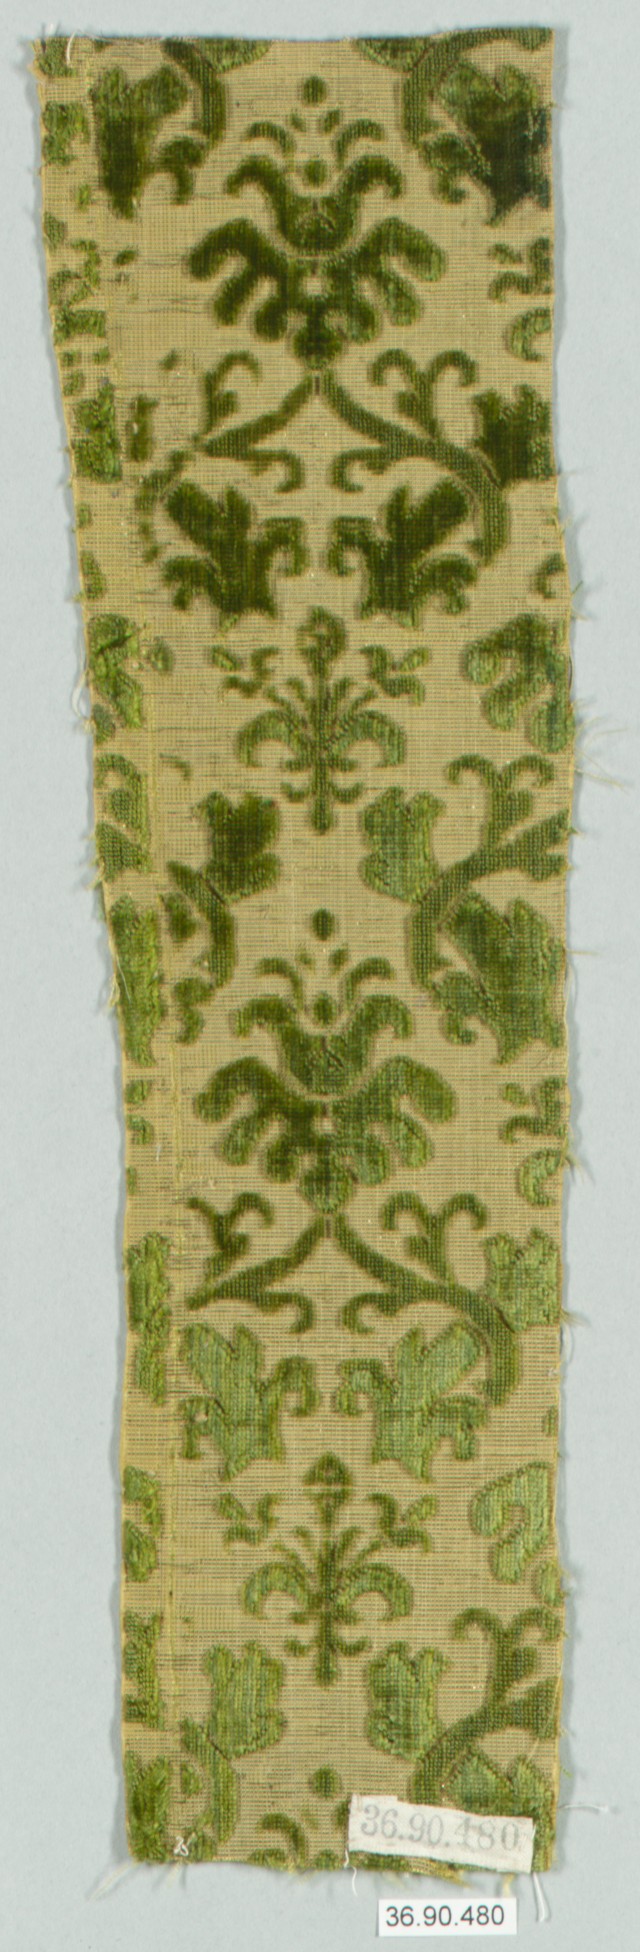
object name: piece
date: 1501-1700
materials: metal thread, silk